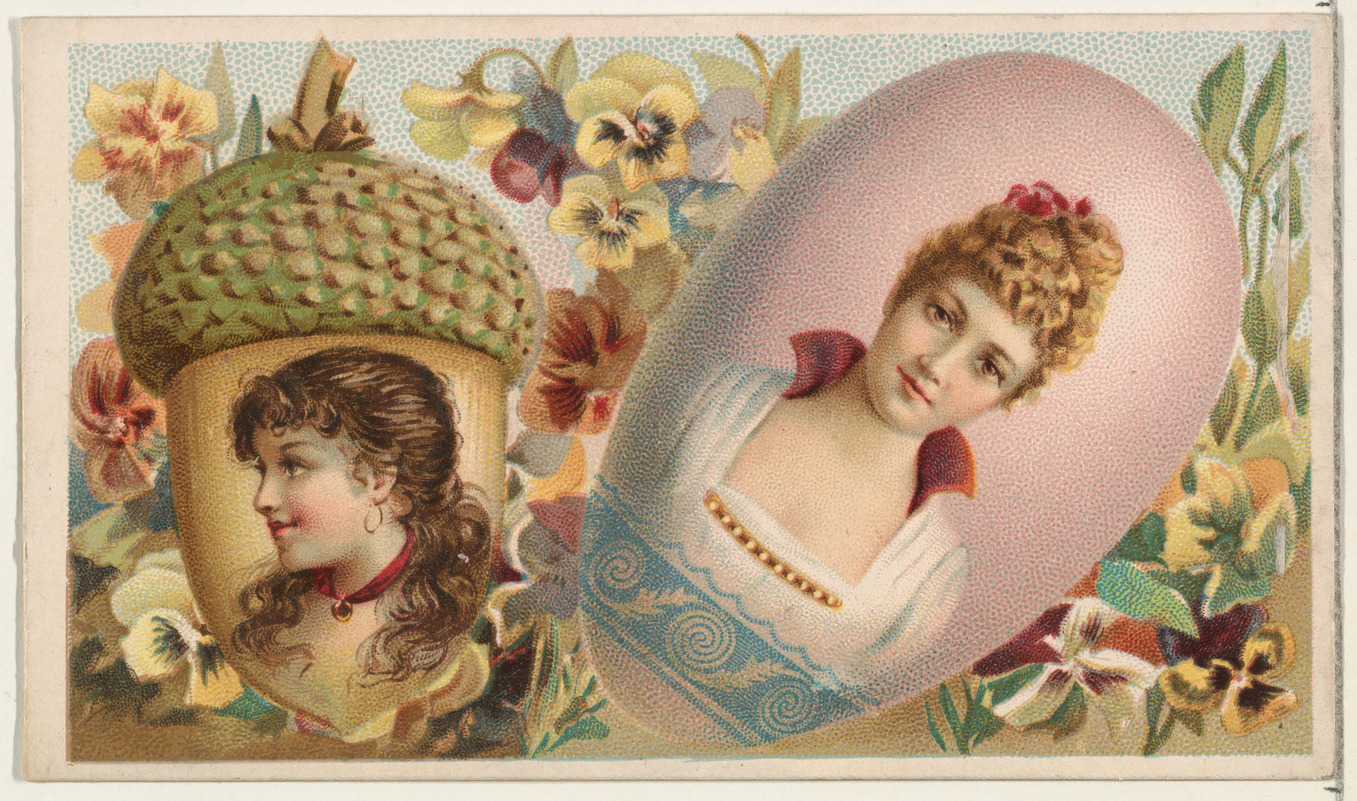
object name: print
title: Acorn, from the Miniature Novelties series (N120) issued by Duke Sons & Co. to promote Honest Long Cut Tobacco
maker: w. duke, sons & co.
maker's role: publisher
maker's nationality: american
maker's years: 1870-1920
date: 1891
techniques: color lithograph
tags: fruit,women